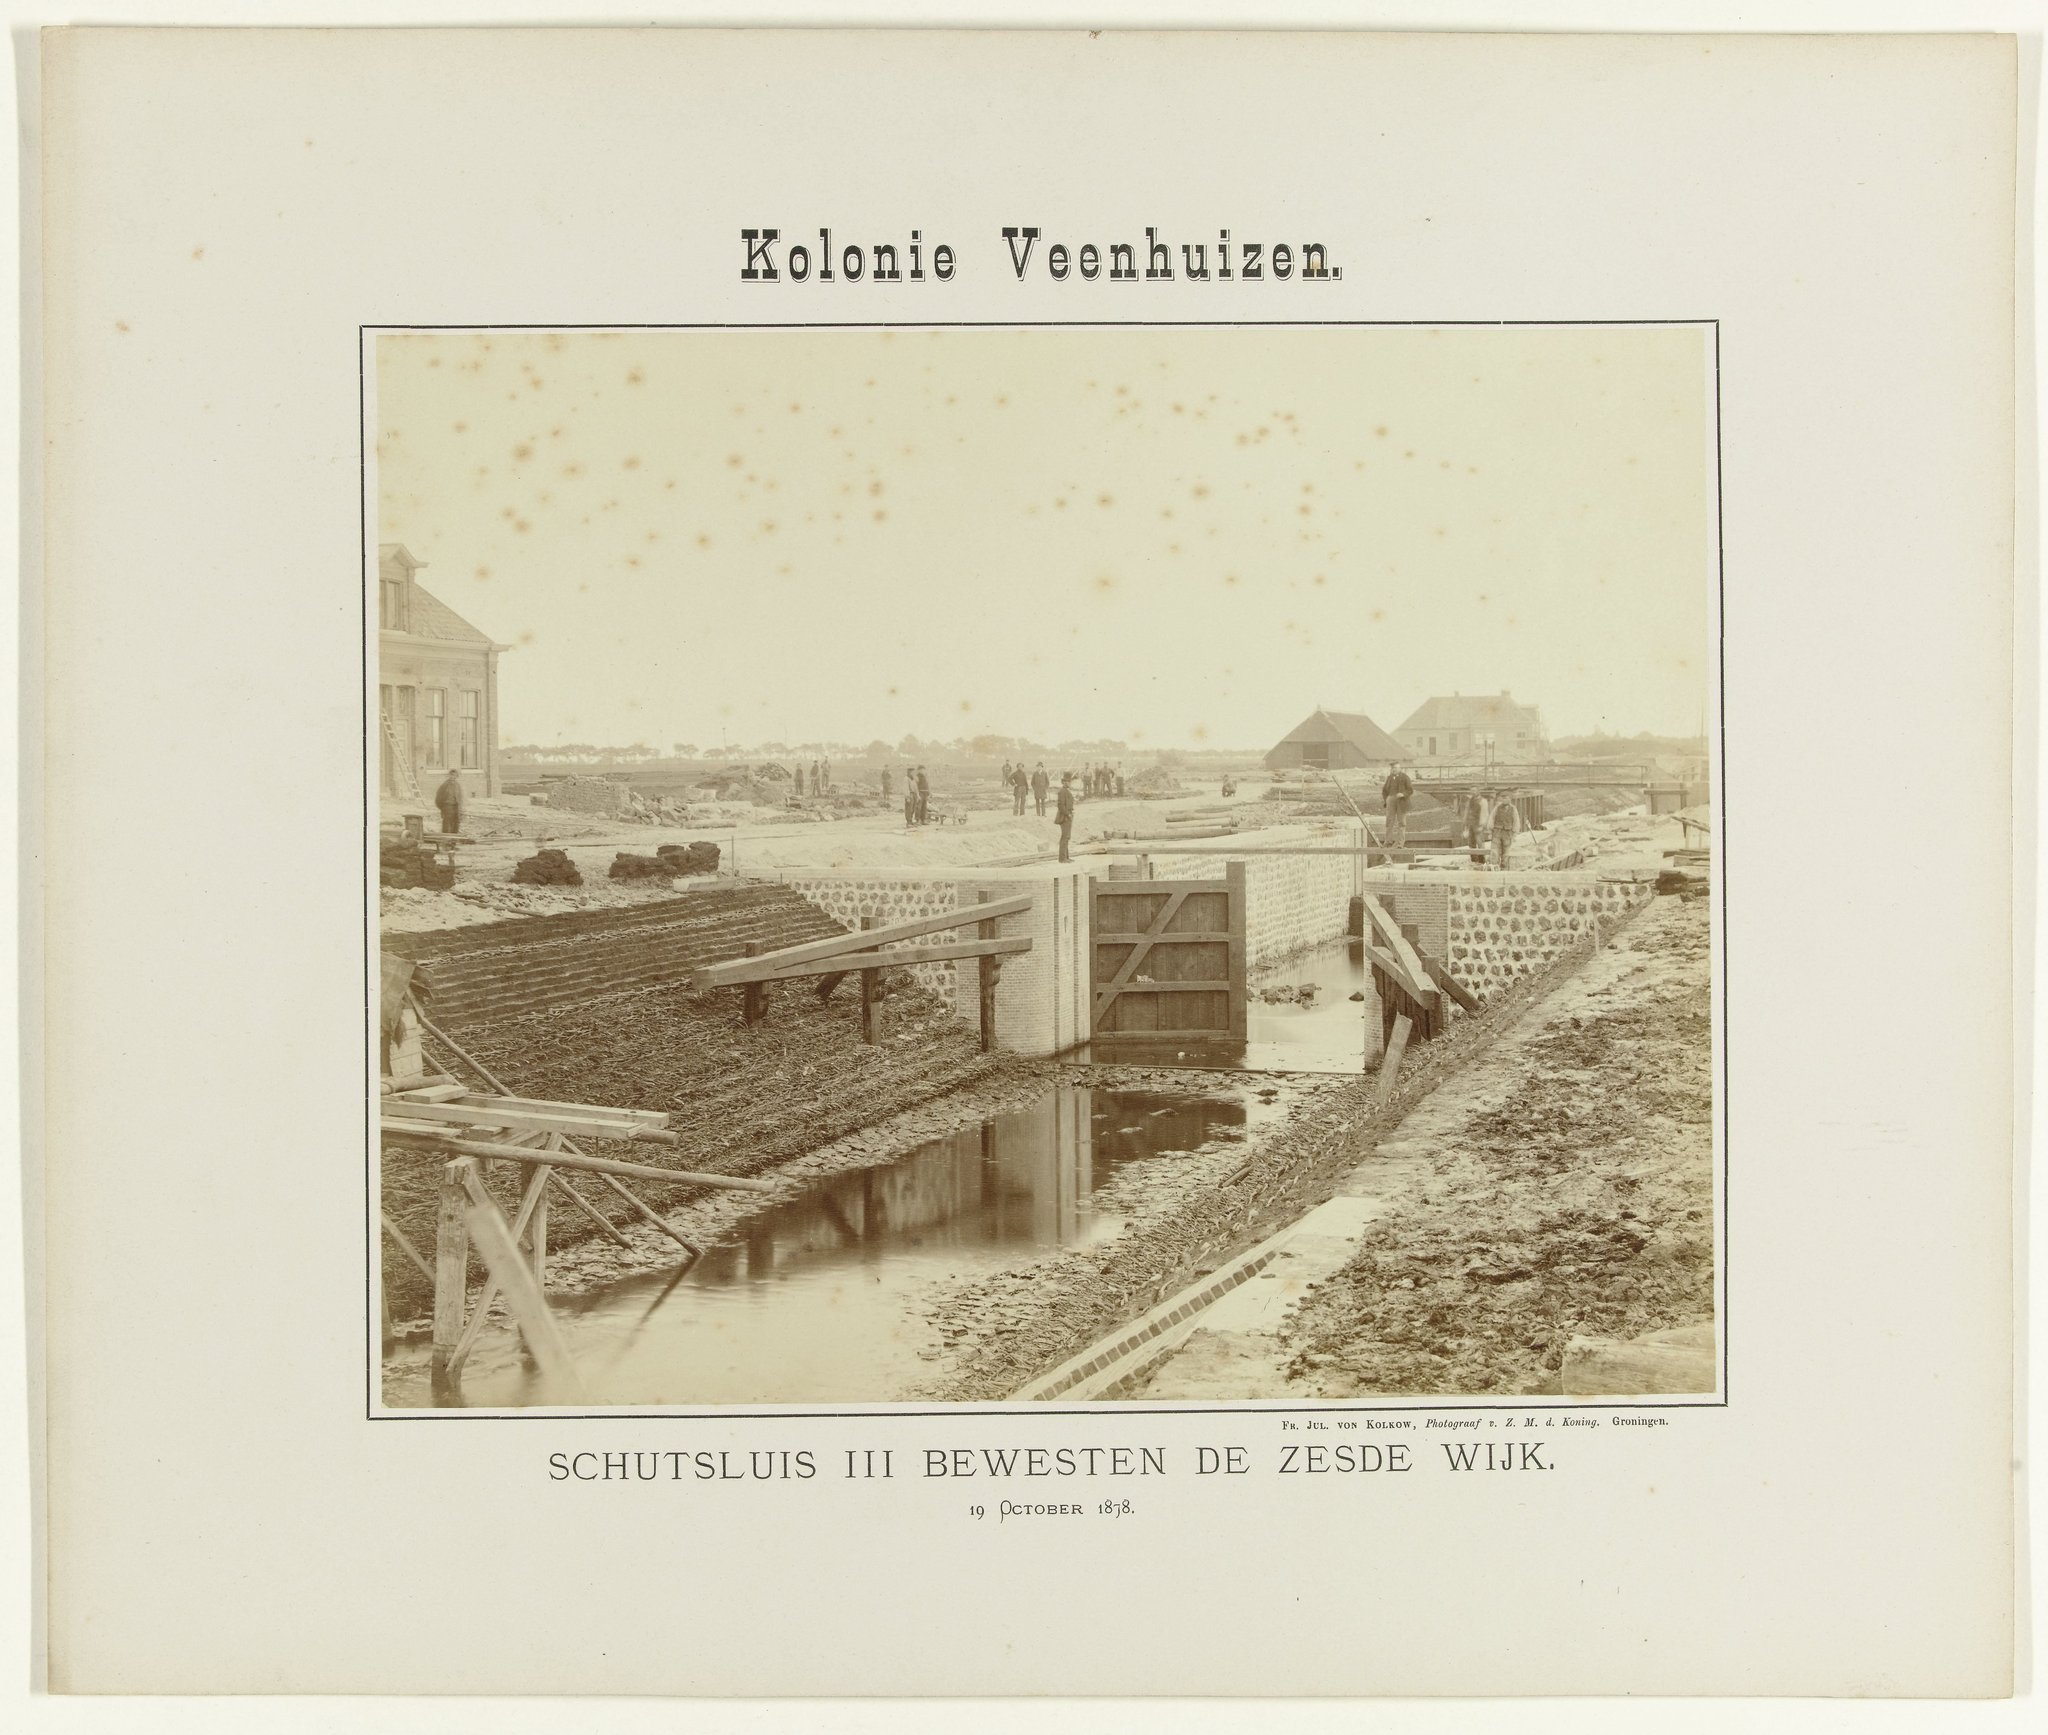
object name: photograph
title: Kolonievaart; afbeelding van Schutsluis nr. 3, te Veenhuizen, gebouwd in 1878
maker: friedrich julius von kolkow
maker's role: fotograaf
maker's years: 1839-1914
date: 1878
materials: cardboard, paper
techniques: photography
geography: groningen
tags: veenhuizen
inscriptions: date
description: De schutsluis werd gebouwd in opdracht van de provincie Drenthe. Er werd zonder machines gewerkt; ook het heien gebeurde met mankracht. De Veenhuizervaart was belangrijk voor het vervoer van de produkten van de kolonie Veenhuizen. Daar werden behoeftige stedelingen omgeschoold tot degelijke boeren.